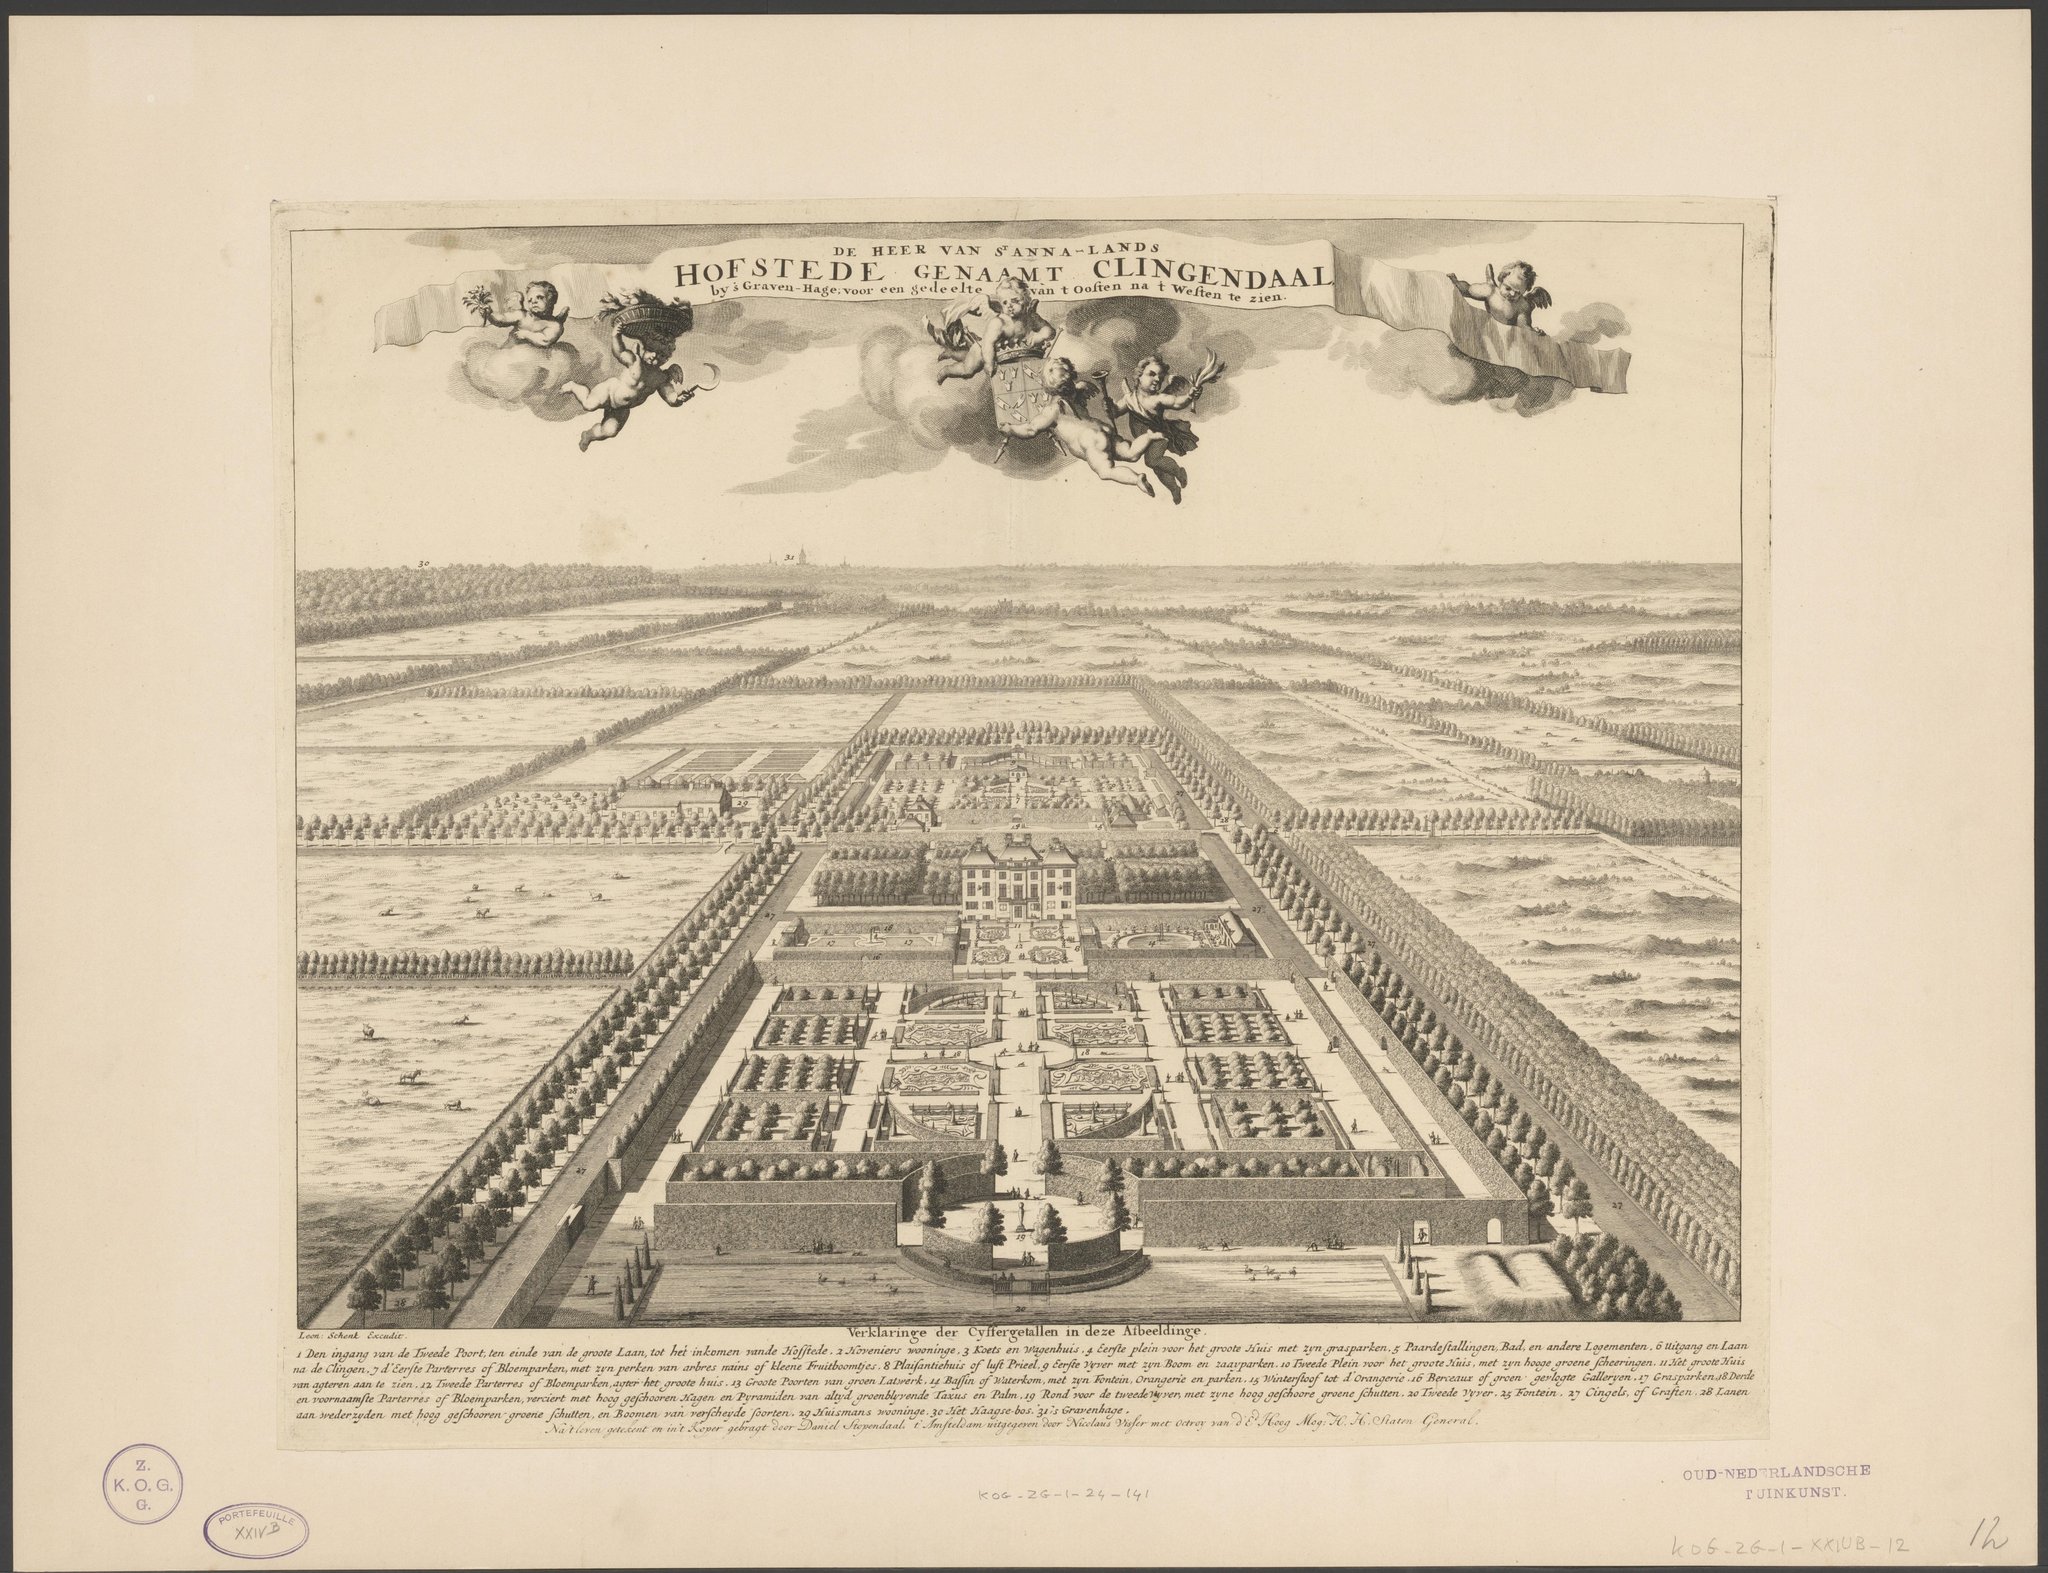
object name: print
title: Landgoed Clingendael in vogelvlucht vanuit het oosten naar het westen gezien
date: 1682-1726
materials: paper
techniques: engraving, etching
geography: amsterdam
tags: philips doublet (ii), french or architectonic garden; formal garden, bird's eye view ~ representation of building, cupids: 'amores', 'amoretti', 'putti', armorial bearing, heraldry, the hague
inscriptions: stamp, stamp, collector's mark: Lugt 1641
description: Gezicht op landgoed Clingendael in vogelvlucht. Midden boven een door putti geflankeerde wimpel en het wapenschild van de eigenaar Philips Doublet. Onder in de marge de legenda 1-31. Onderwerpsrubrieken binnen de Atlas Zeden en Gewoonten: Zeden en Gewoonten in Engeren Zin, De Woning, Oude Nederlandsche Tuinkunst. De kasteeltuin.